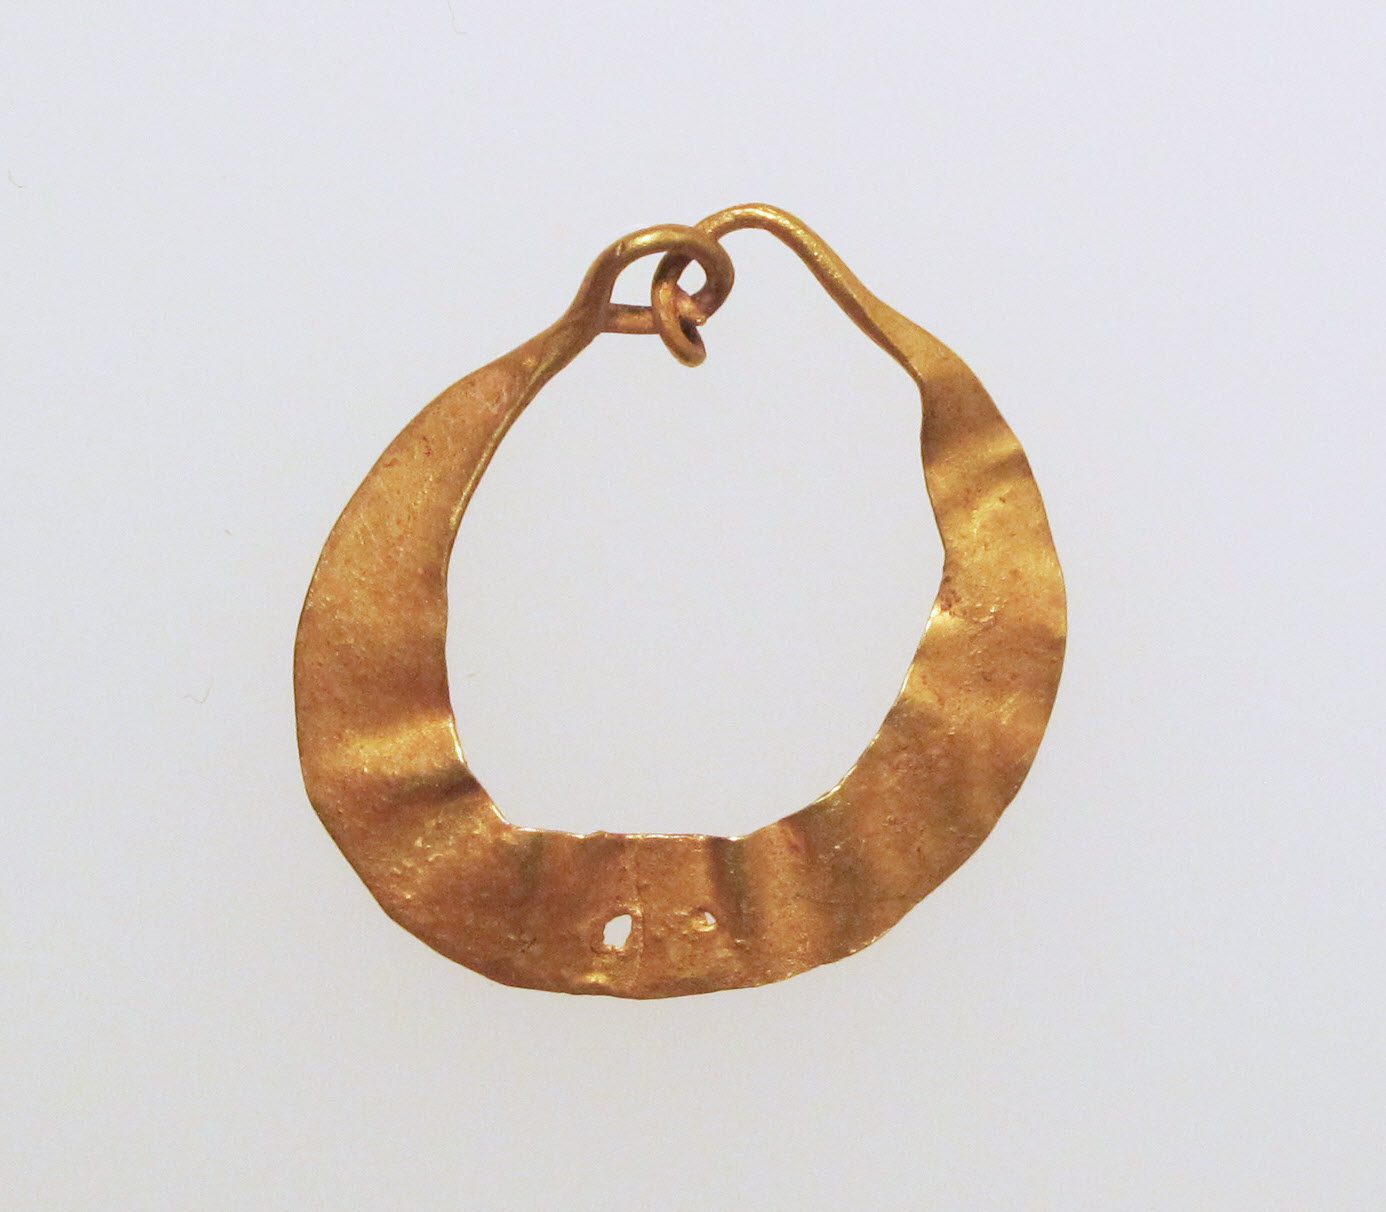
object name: earring, crescent shaped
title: Earring, crescent-shaped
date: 7000 BCE-330 CE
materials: gold